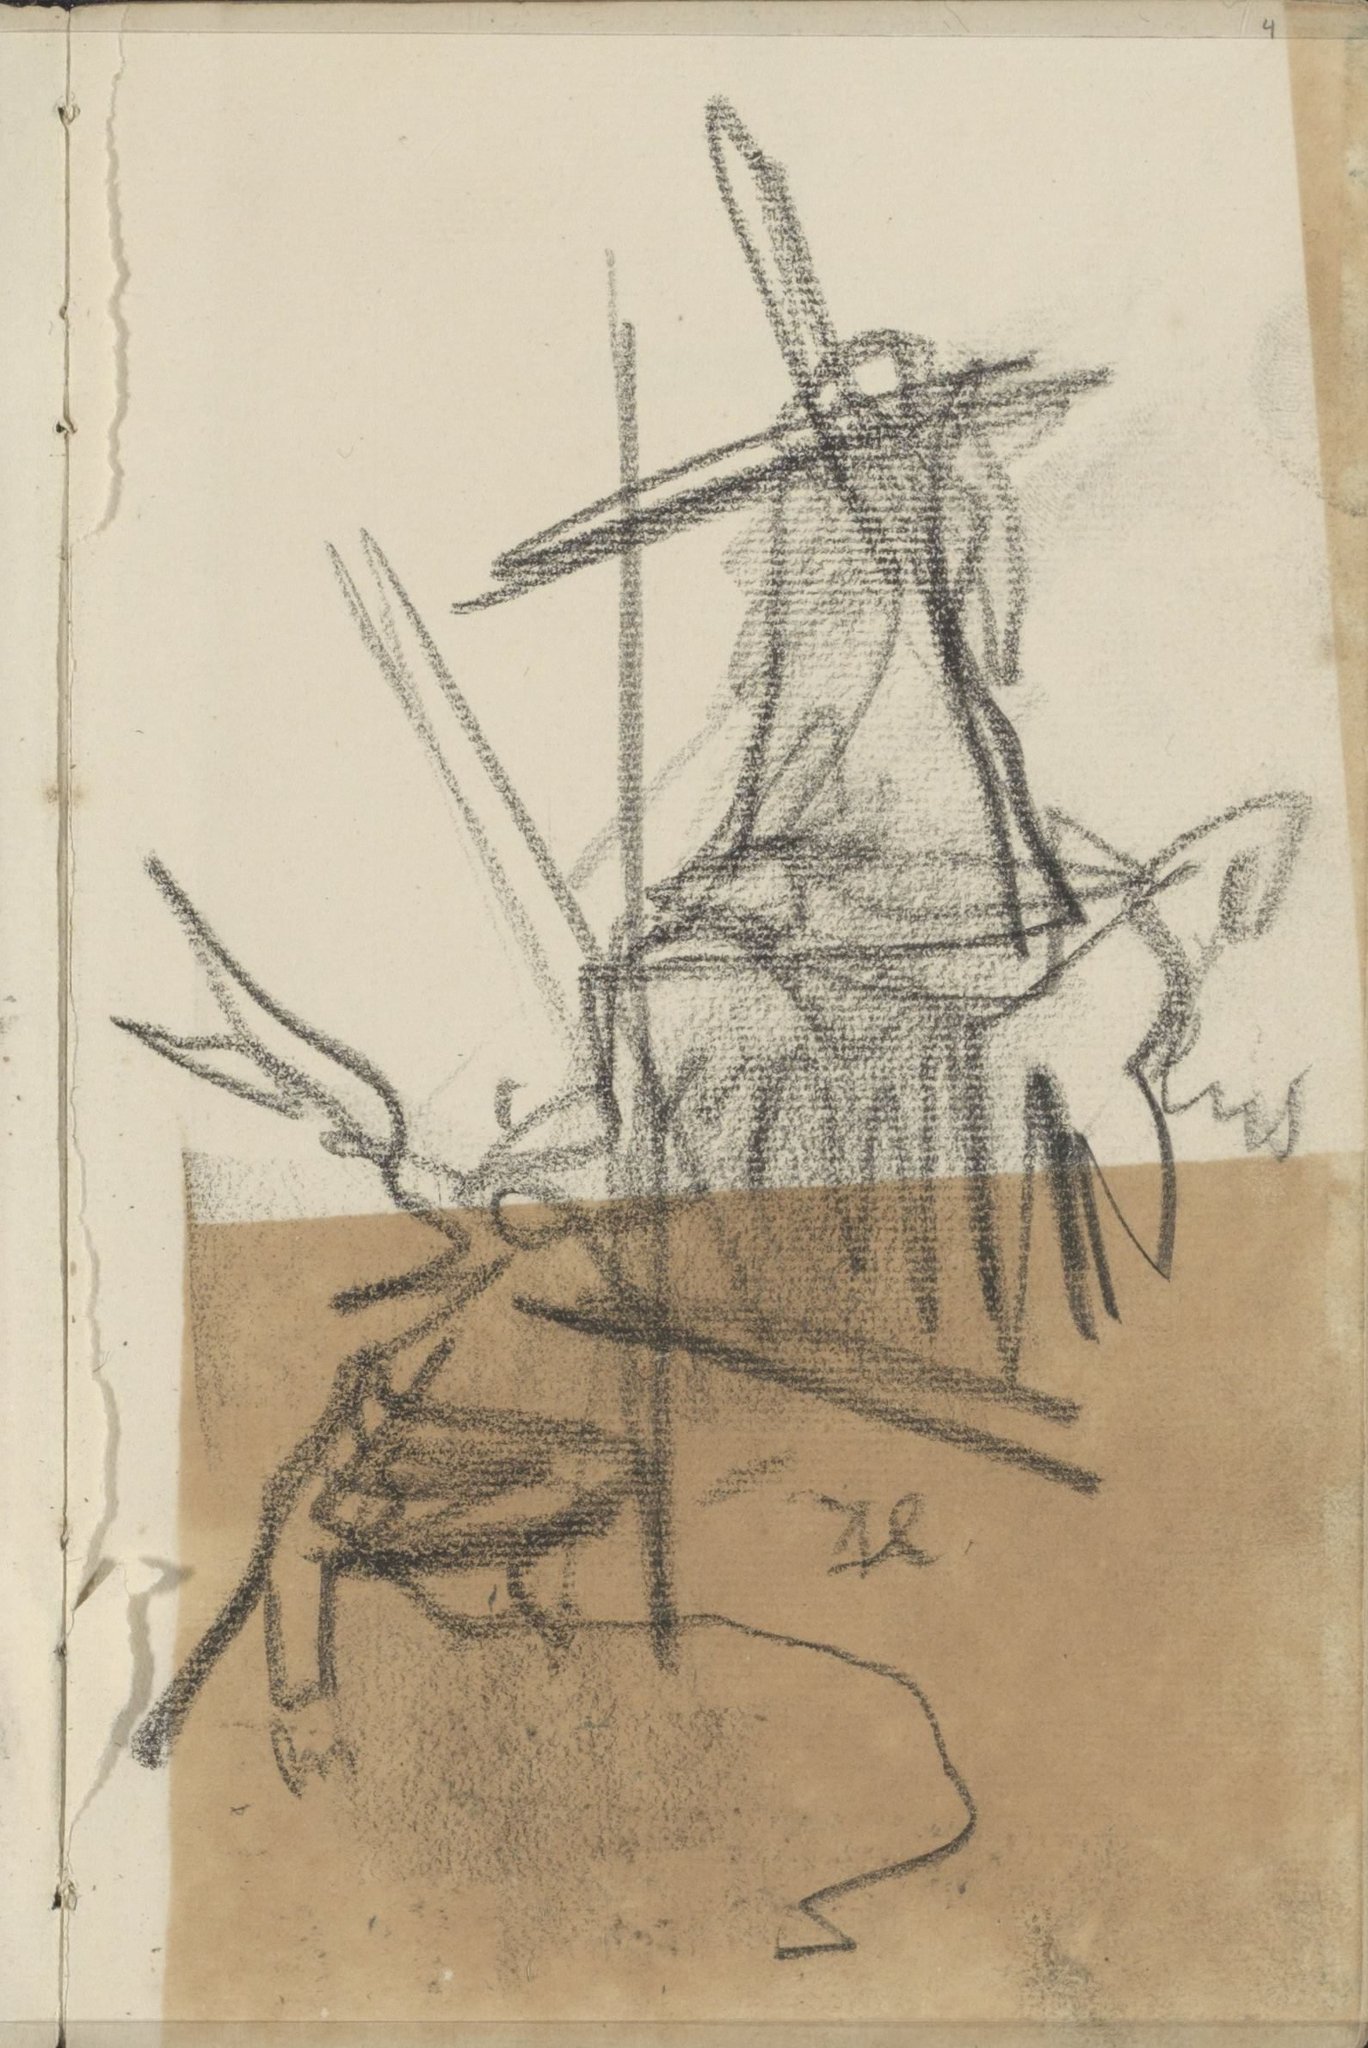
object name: sketchbook leaf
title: Molen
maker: george hendrik breitner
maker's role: draughtsman, painter, print maker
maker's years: 1857-1923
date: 1886-1898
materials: chalk, paper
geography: amsterdam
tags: windmill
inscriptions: annotation: ‘[...]’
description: Pagina 4 uit een schetsboek met 18 bladen.